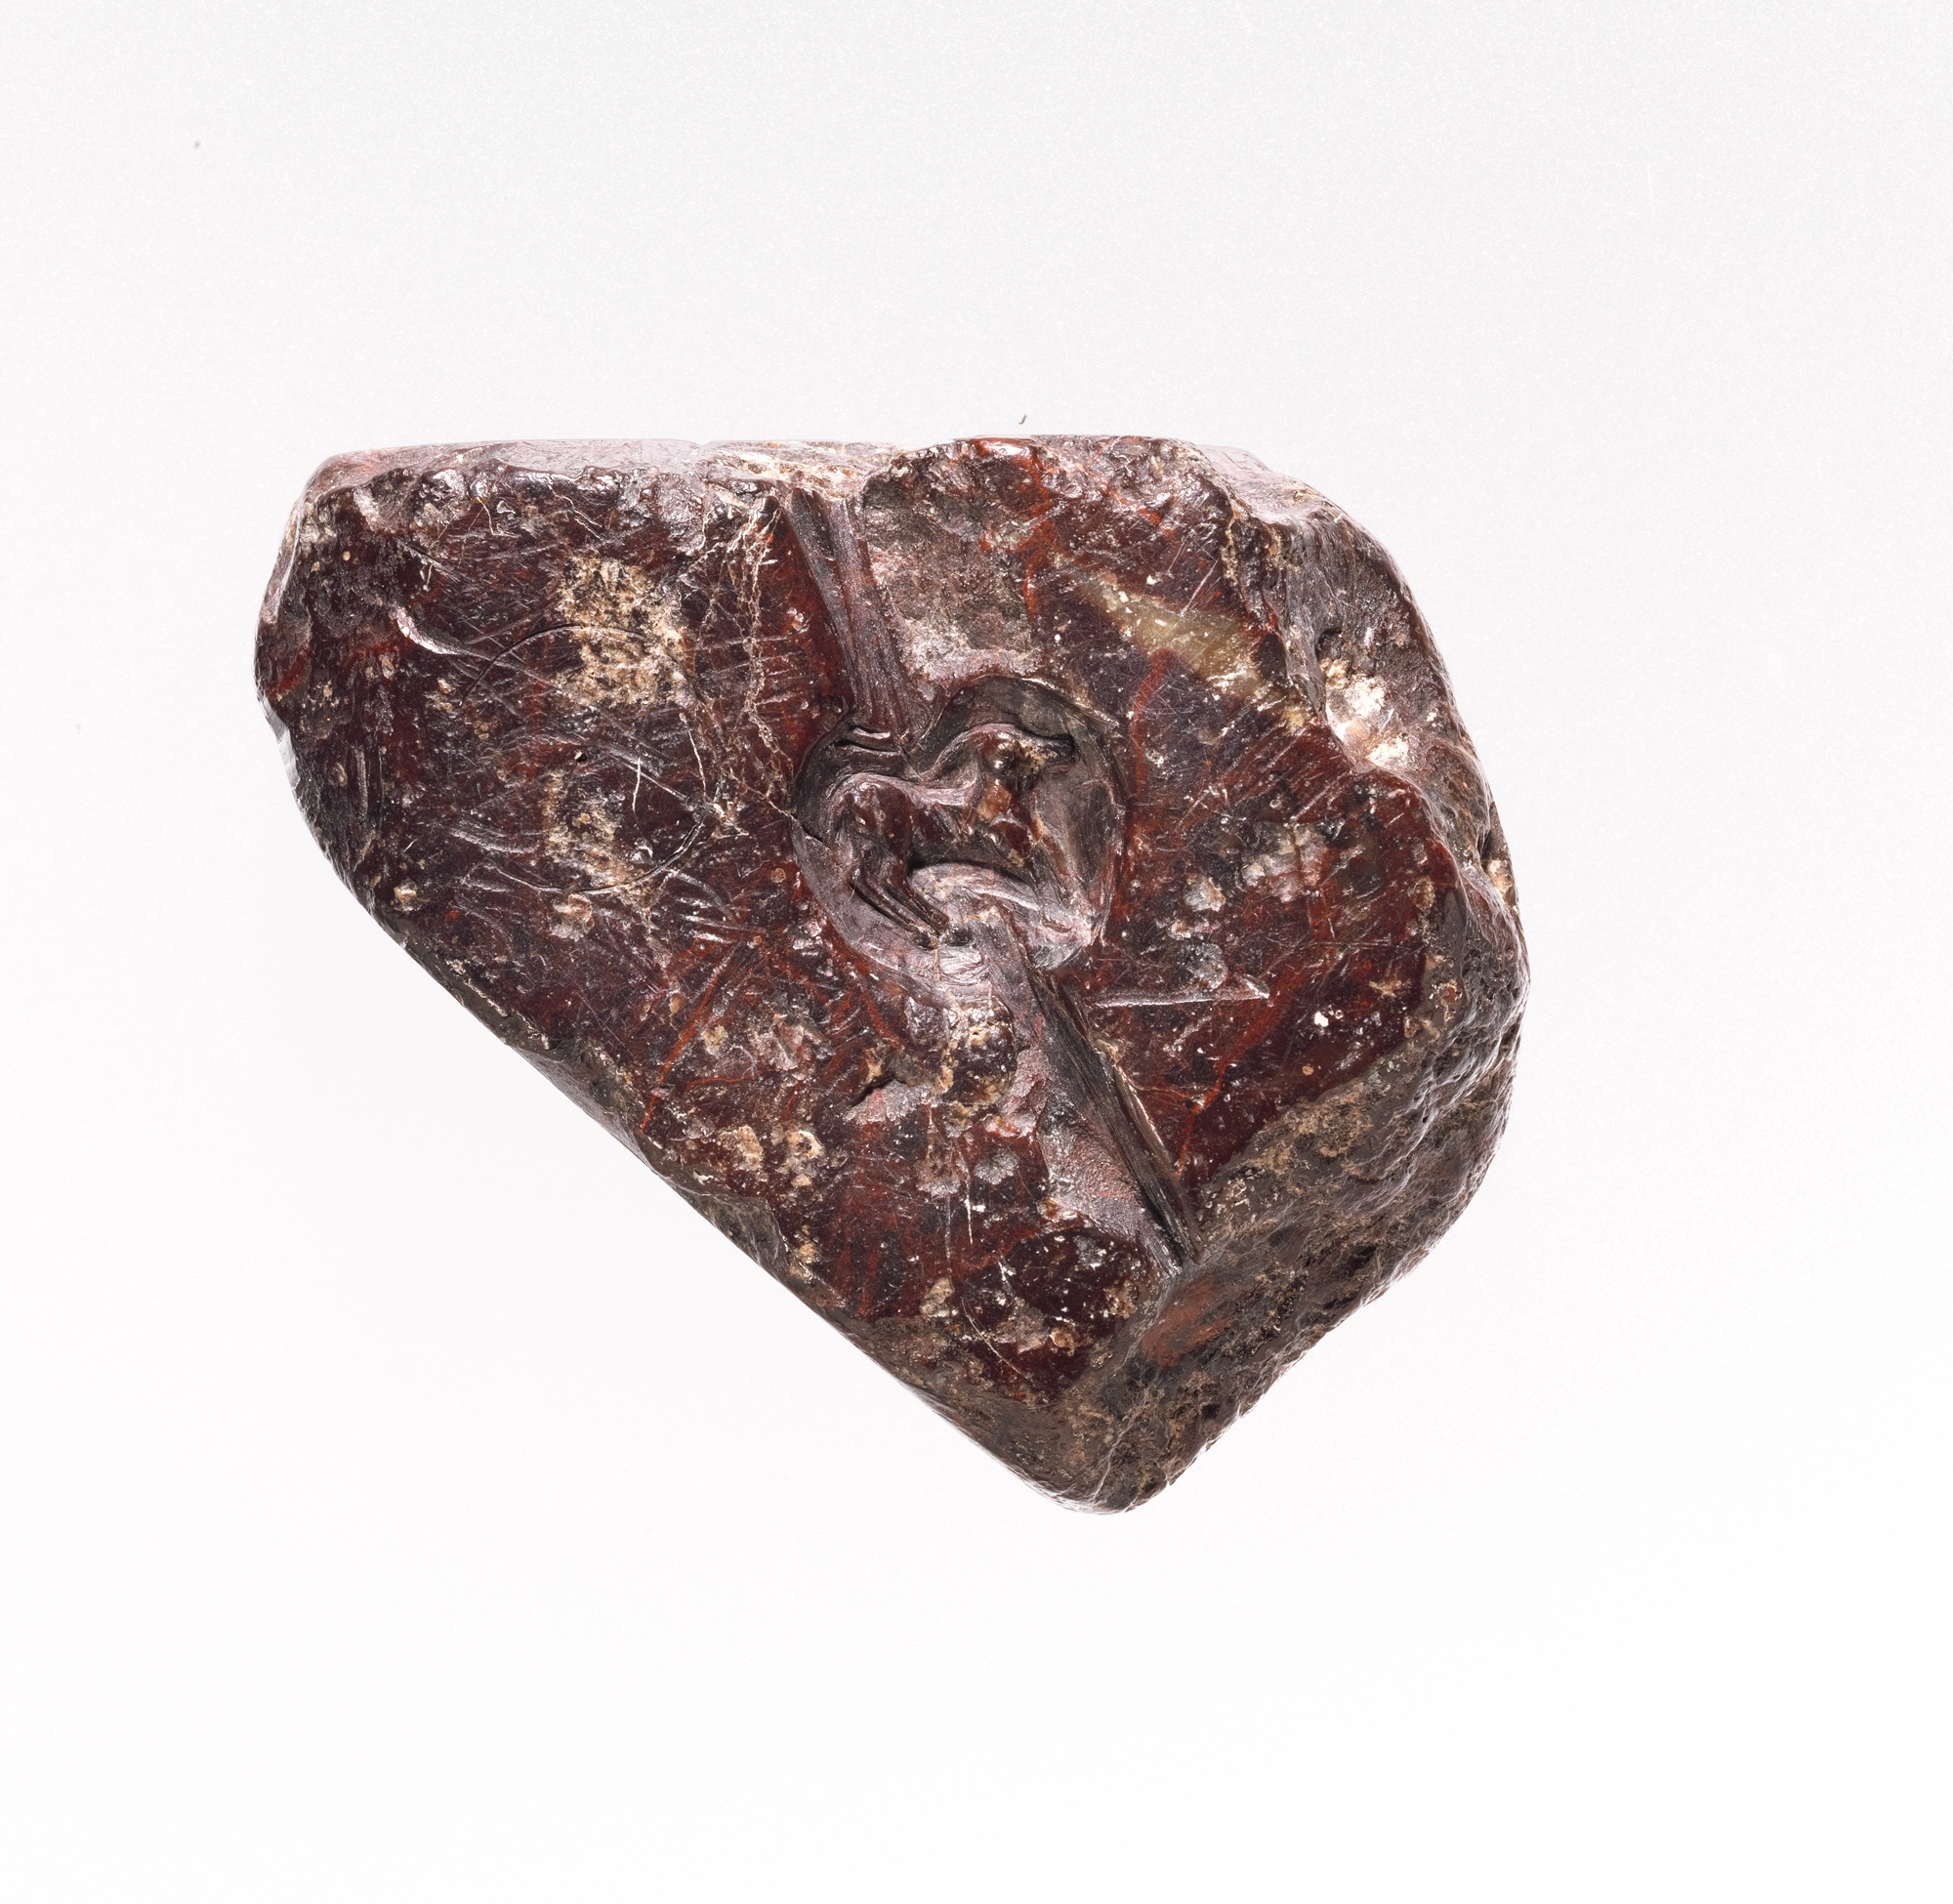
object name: block with intaglio motif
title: Steatite block with intaglio motifs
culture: minoan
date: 1400-1200 BCE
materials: stone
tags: animals